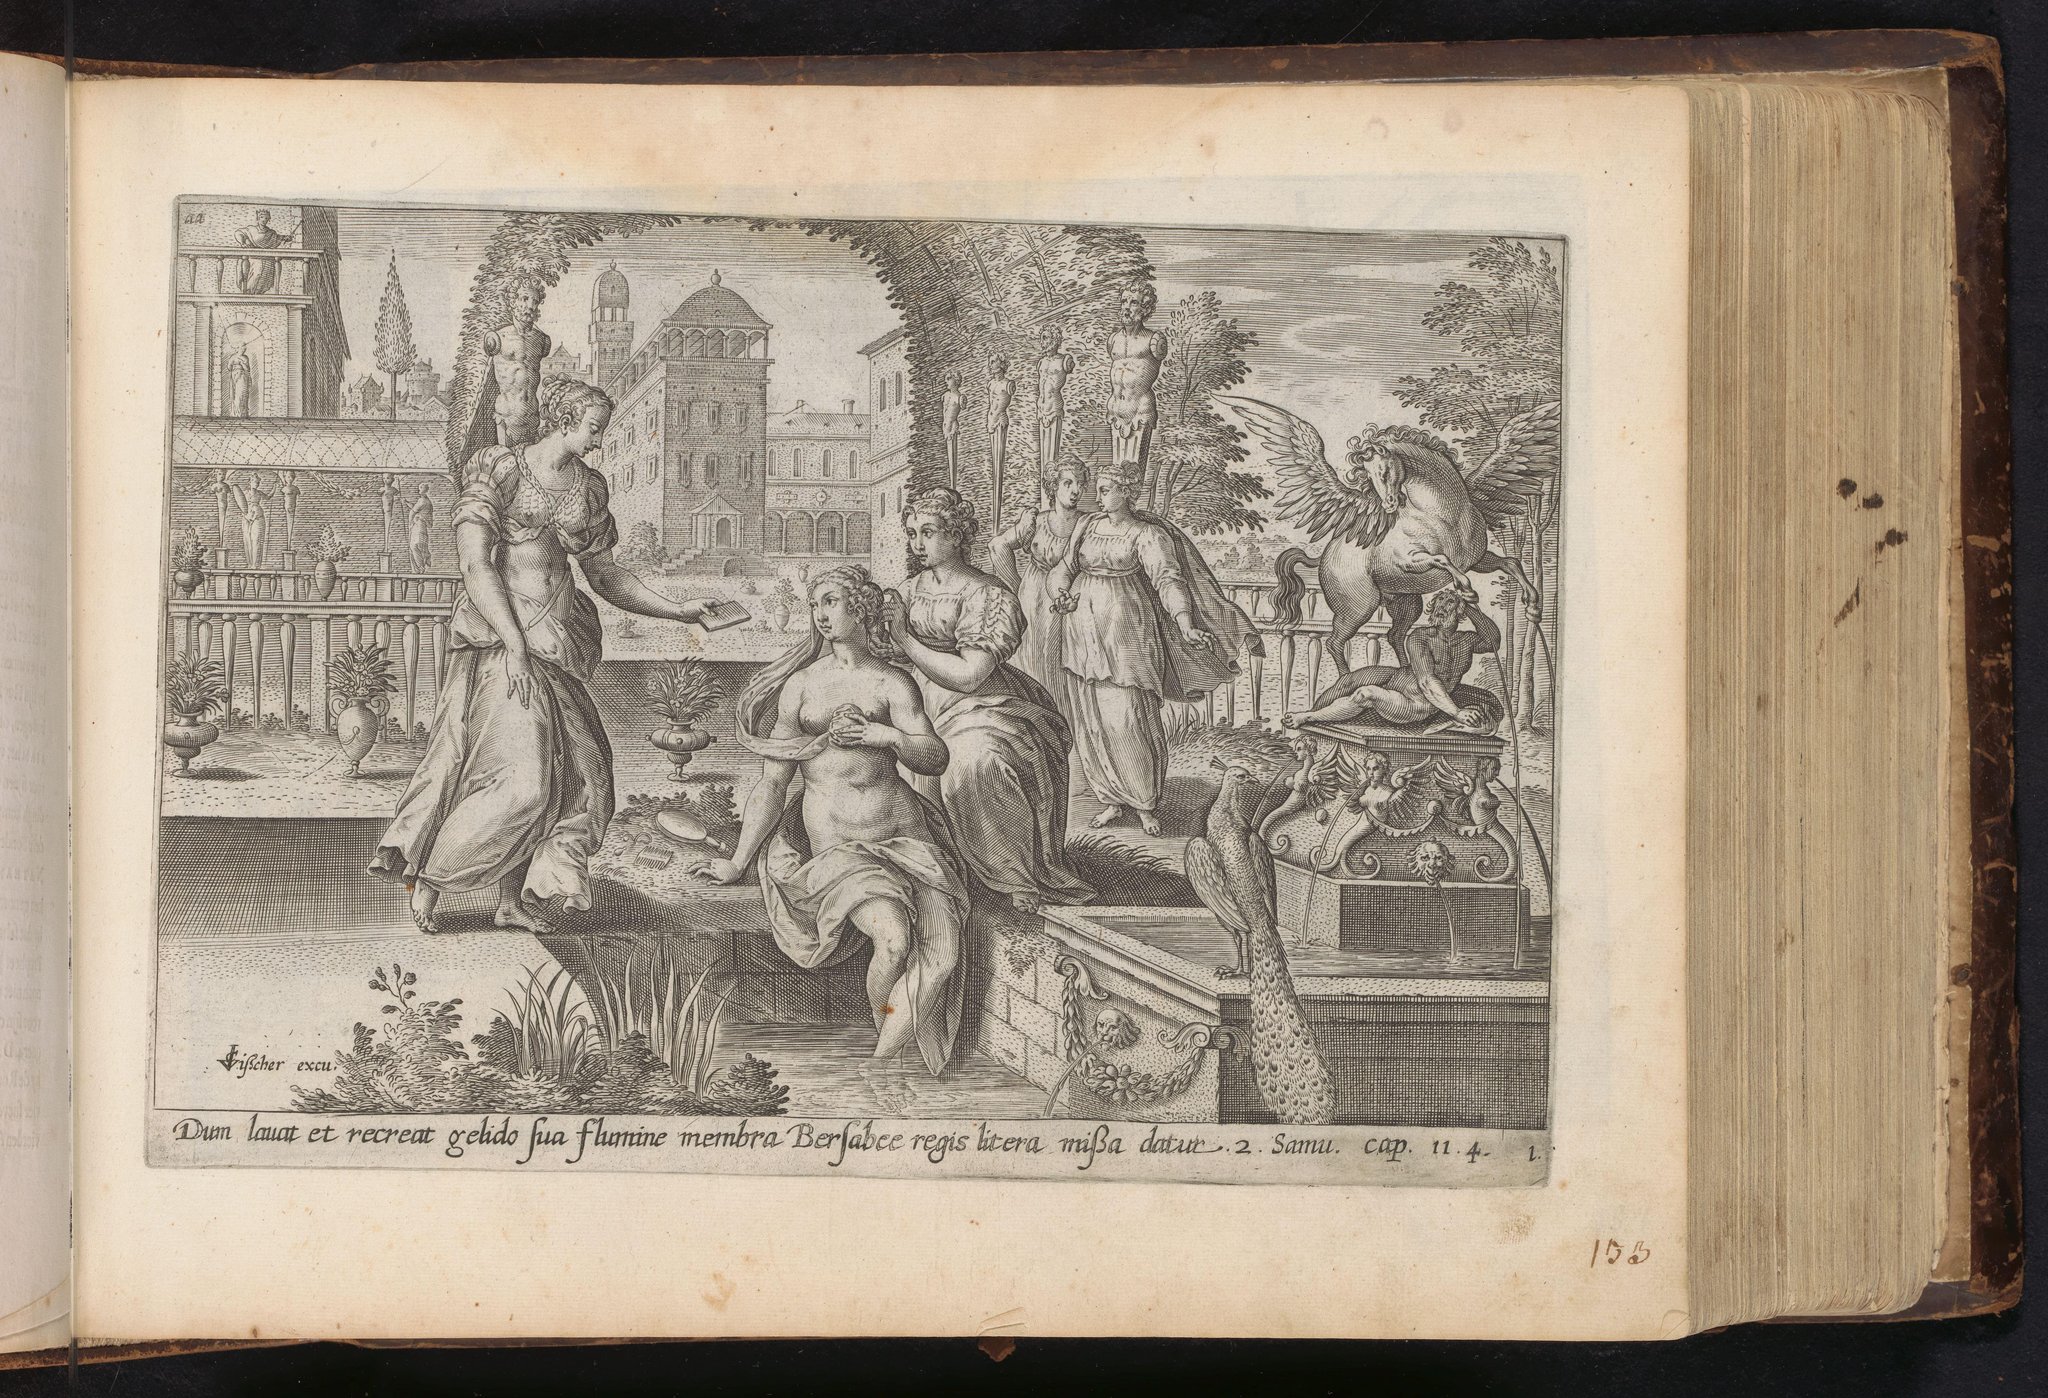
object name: album leaf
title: Geschiedenis van David en Batseba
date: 1585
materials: paper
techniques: engraving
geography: amsterdam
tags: garden fountain, bathsheba receives a letter from david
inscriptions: number: ‘153’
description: Batseba, vergezeld door dienaressen, zit op de rand van een waterbassin bij een fontein. Een bediende reikt haar een brief aan van koning David. David staat op het balkon van het paleis links op de achtergrond. Onder de voorstelling een verwijzing in het Latijn naar de Bijbeltekst in 2 Sam. 11:4. Deze prent maakt deel uit van een album.